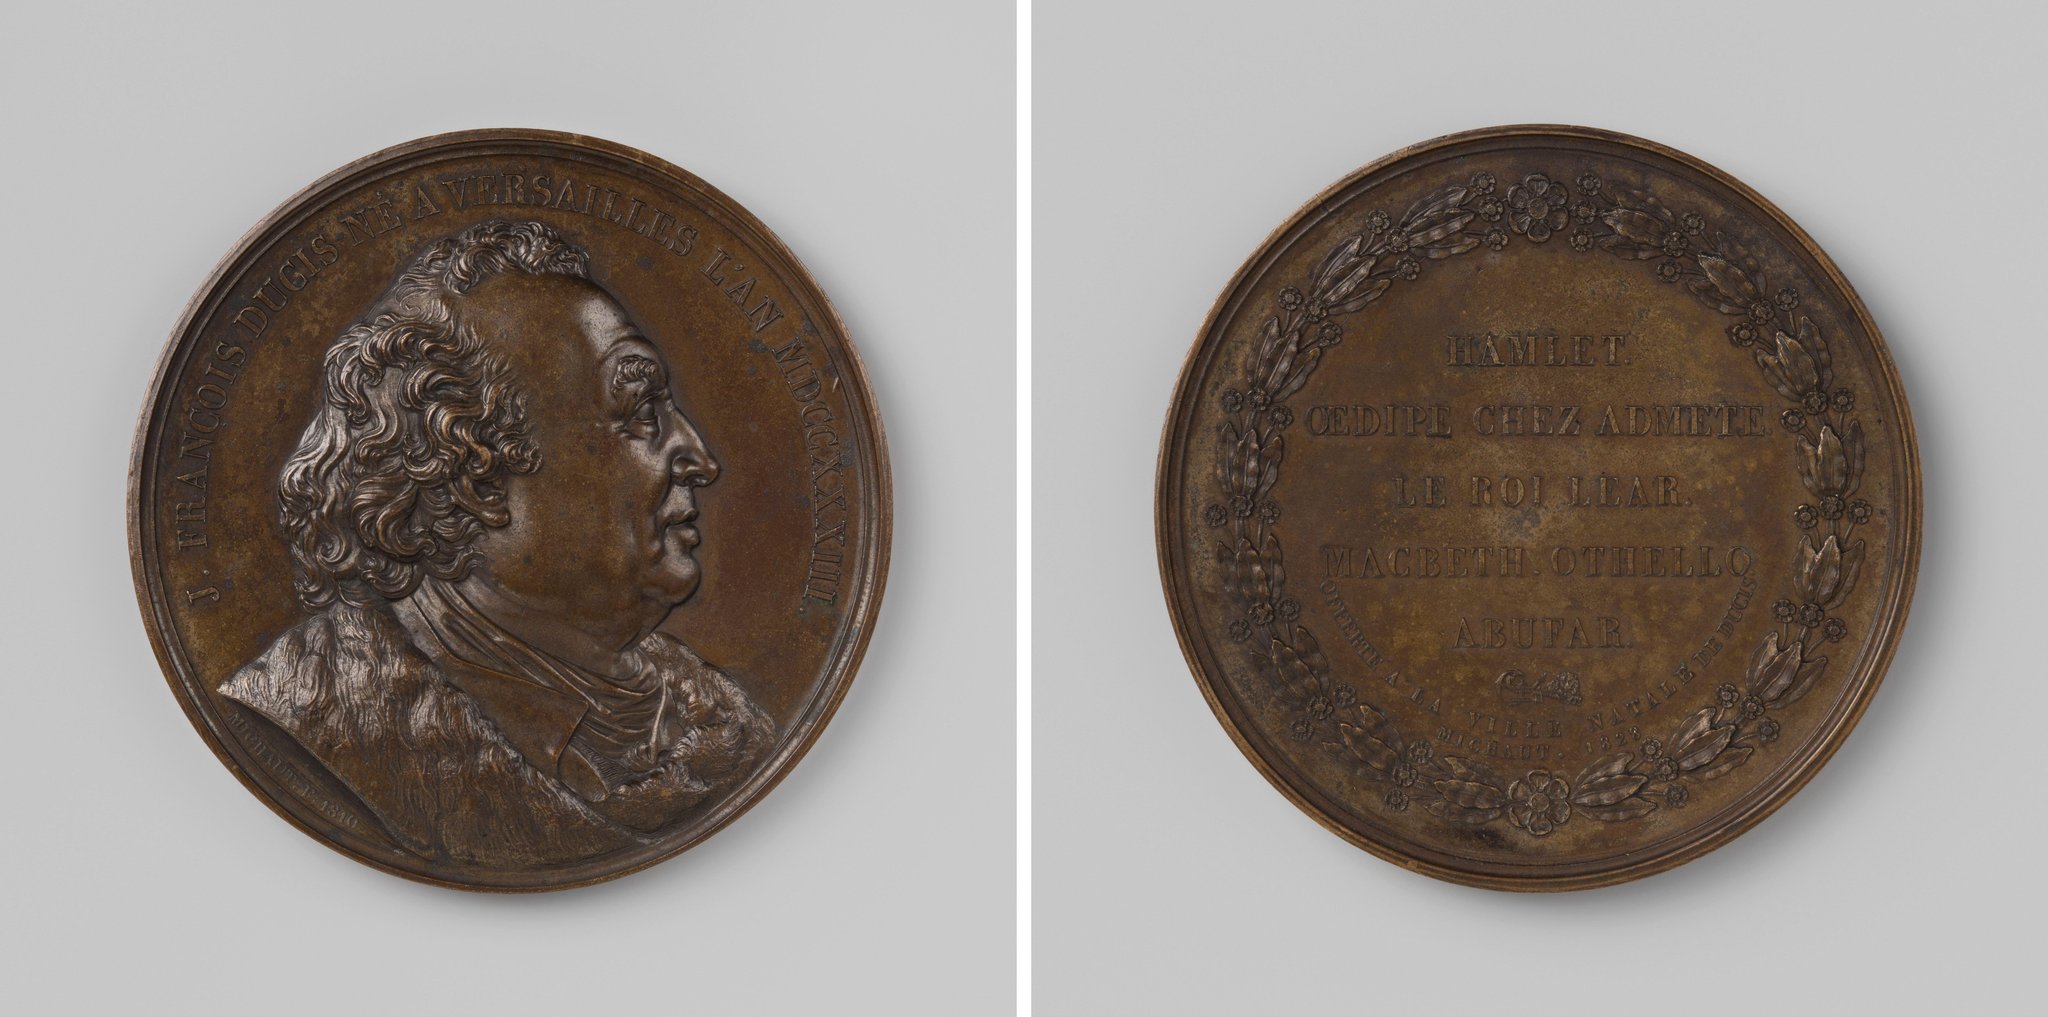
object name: history medal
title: Jean Francois Ducis, toneelschrijver, penning aangeboden aan zijn geboortestad Versailles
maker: auguste francois michaut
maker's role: sculptor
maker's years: 1786-1879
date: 1810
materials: bronze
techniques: striking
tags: toneelschrijver, jean françois ducis, versailles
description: Bronzen penning. Voorzijde: borststuk man binnen omschrift. Keerzijde: opschrift binnen myrtekrans